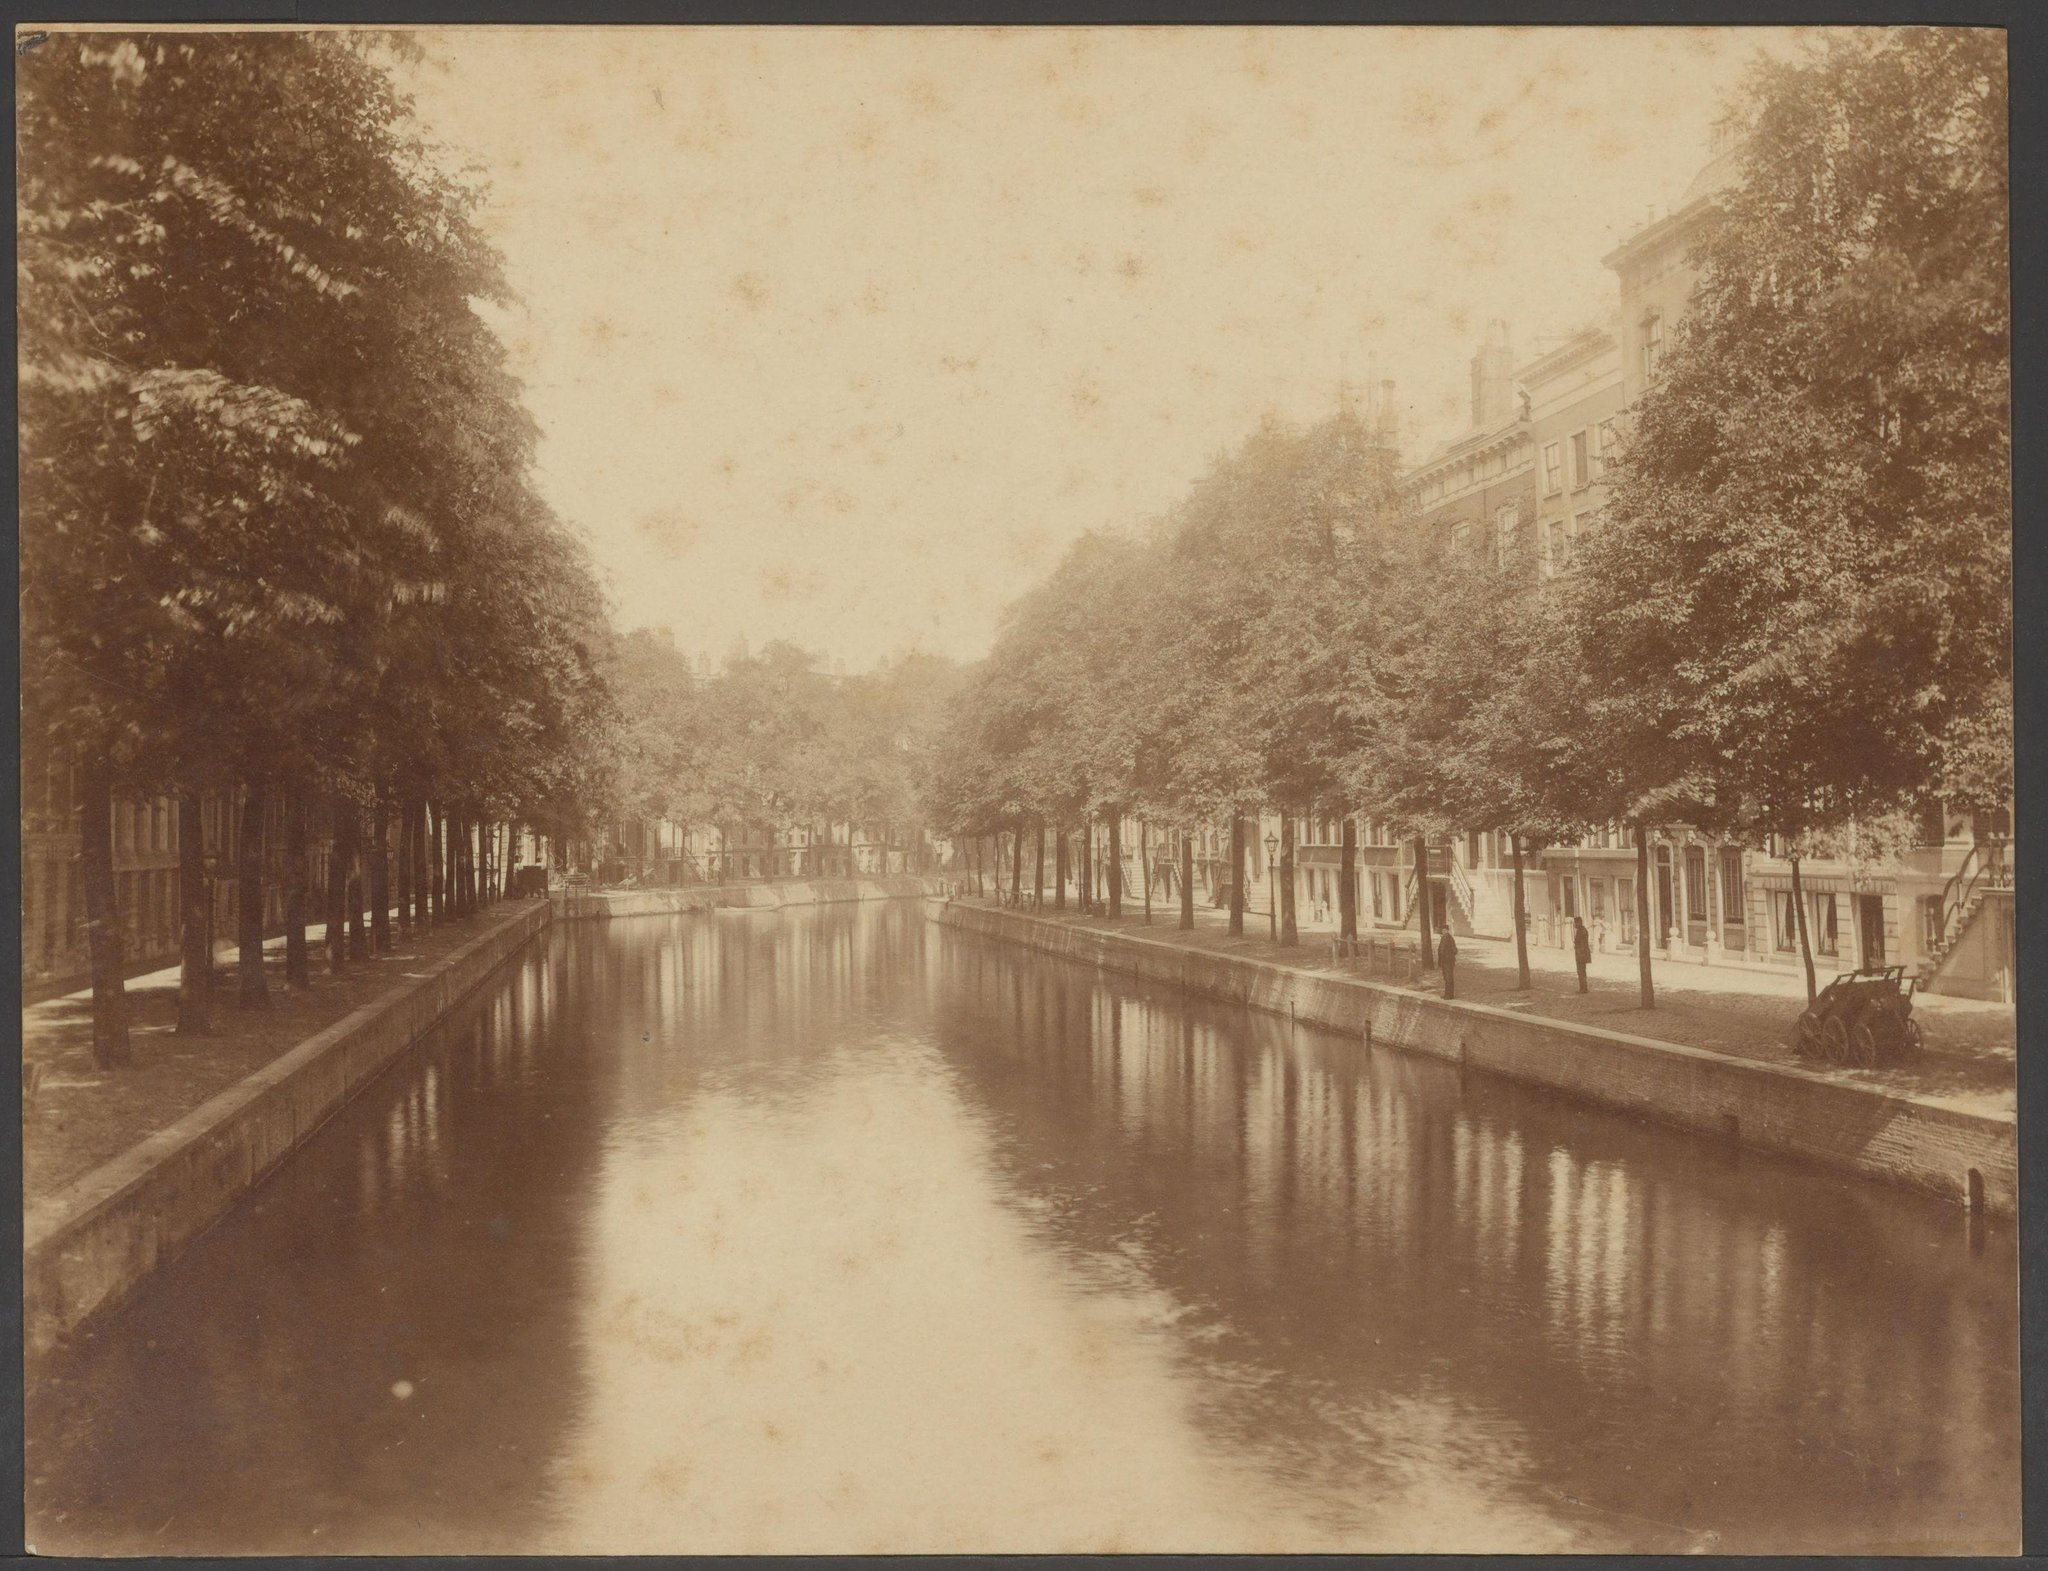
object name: photomechanical print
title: Gezichten op de markt in enkele straten rondom de Jodenbreestraat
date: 1875-1925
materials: paper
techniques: letterpress printing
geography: amsterdam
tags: city-view in general; 'veduta', stall, booth (~ market), street, marketing, shopping (~ household management)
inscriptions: collector's mark: ‘8,130’ Lugt 1641b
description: Onderwerpsrubriek binnen de Atlas Amsterdam: Jacobszstraat (Pieter), Jodenbreestraat, Jodenhoek, Jonge Roelensteeg, Jonker- en Ridderstraat.